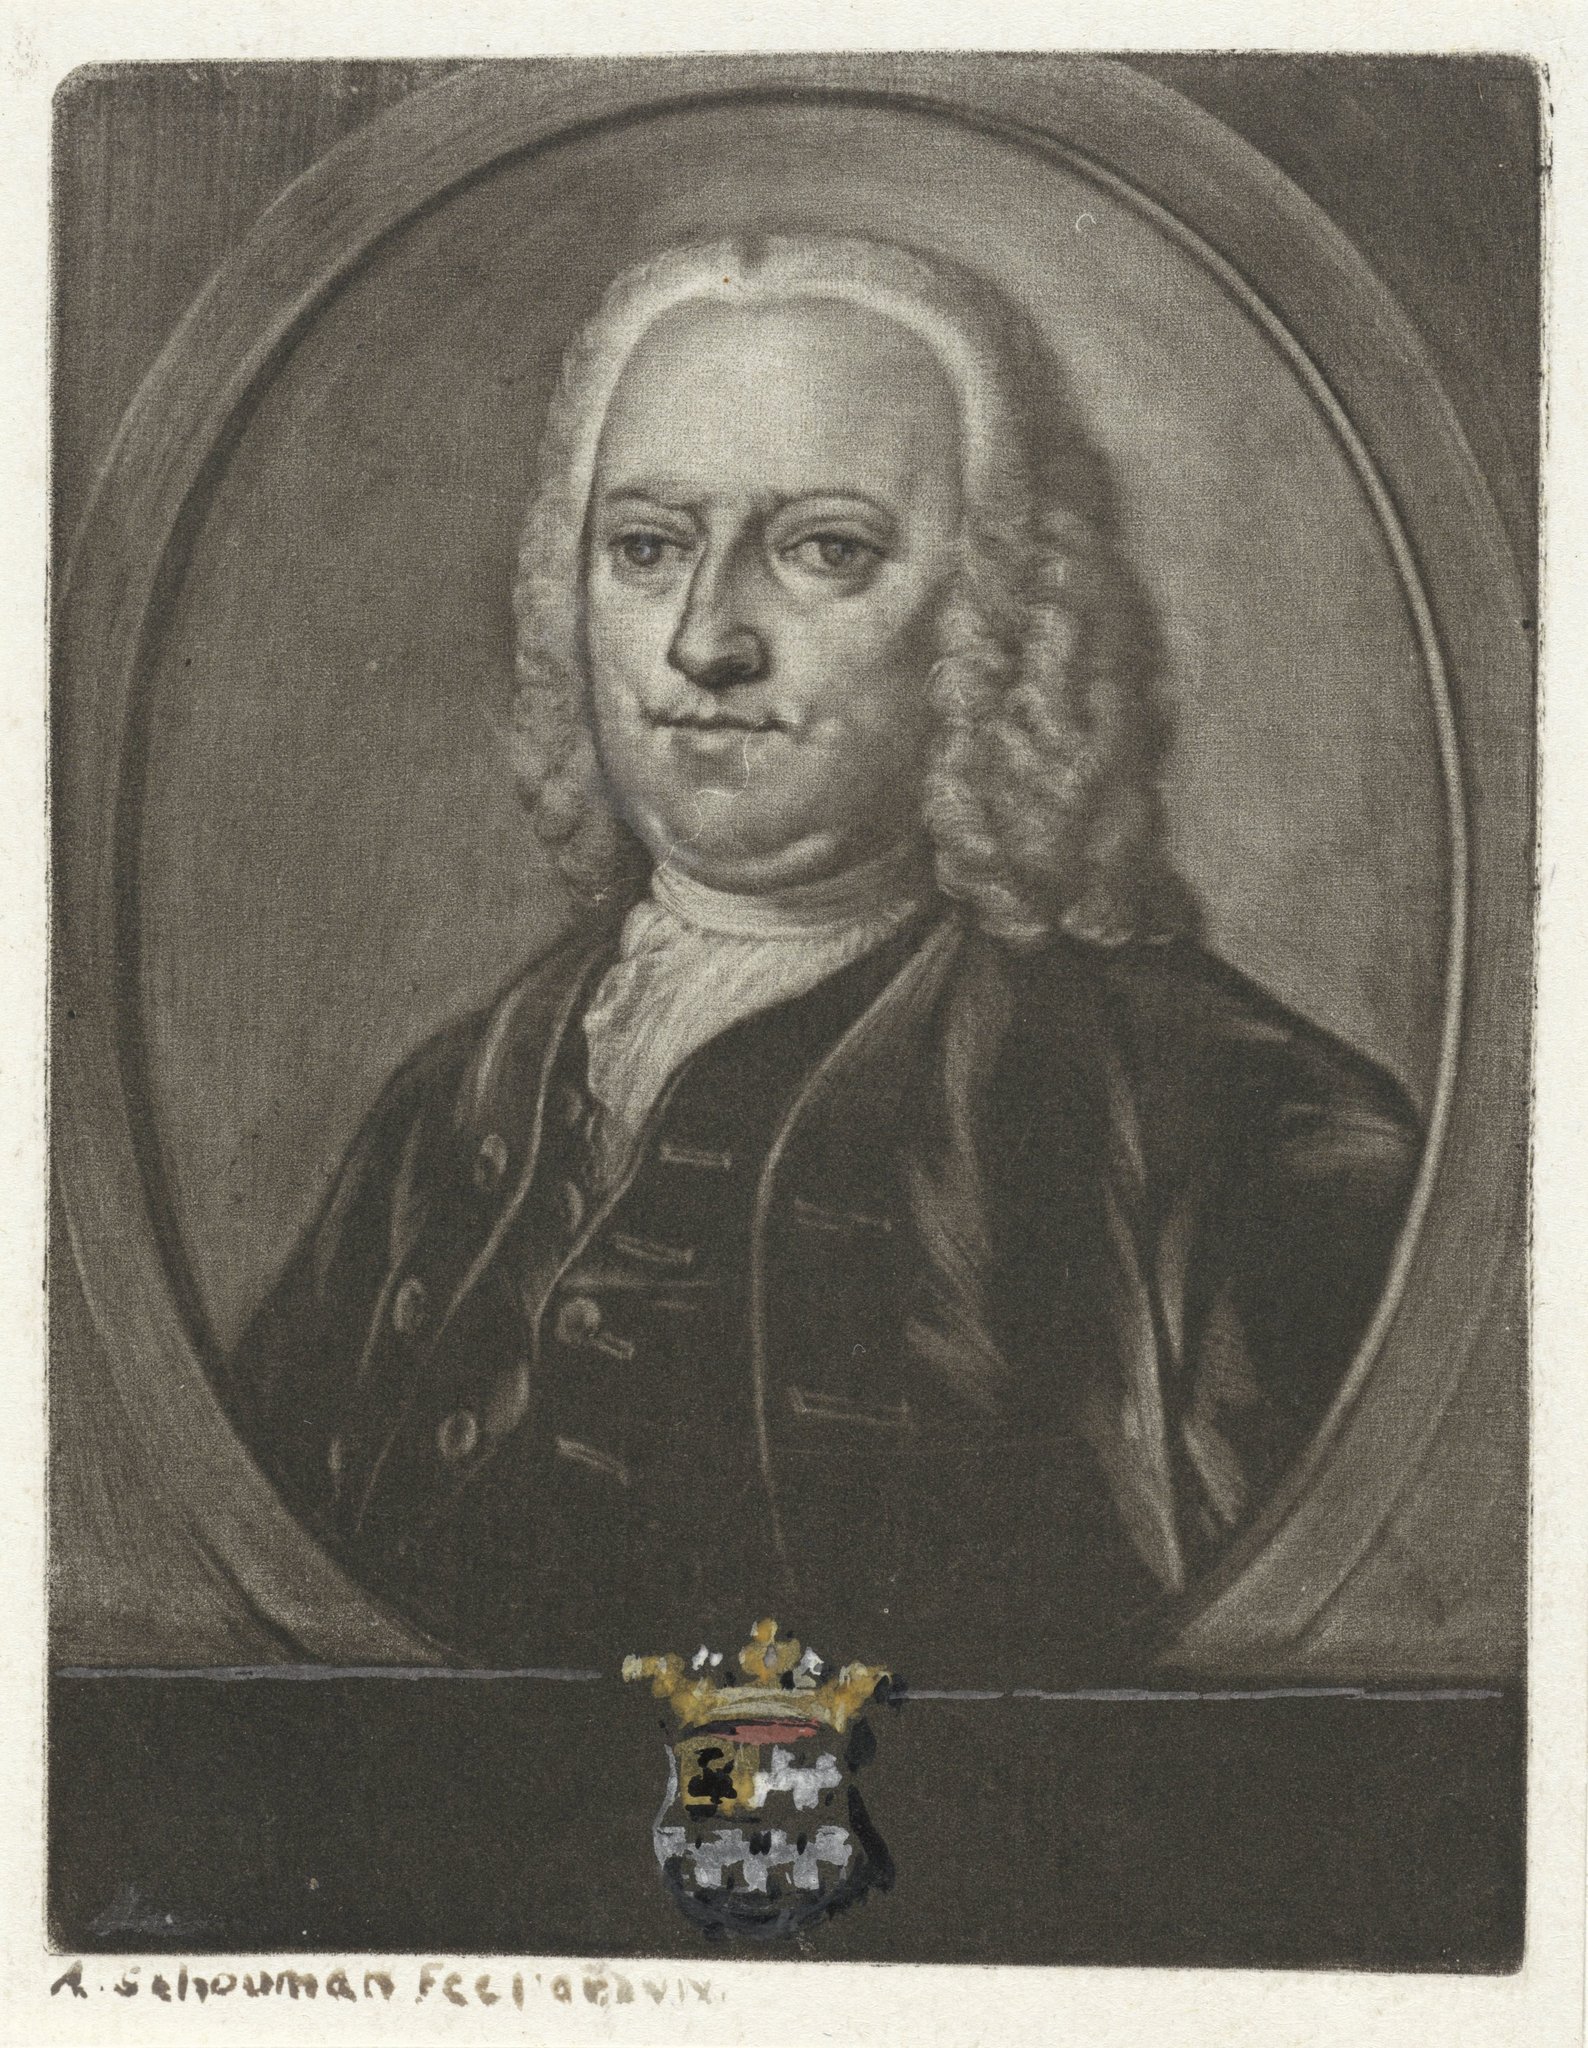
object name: print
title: Portret van een man, mogelijk Johan van der Linden van Slingeland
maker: aert schouman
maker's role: draughtsman, painter, print maker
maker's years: 1710-1792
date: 1720-1792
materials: paper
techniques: brush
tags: armorial bearing, heraldry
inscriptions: collector's mark: Lugt 2228